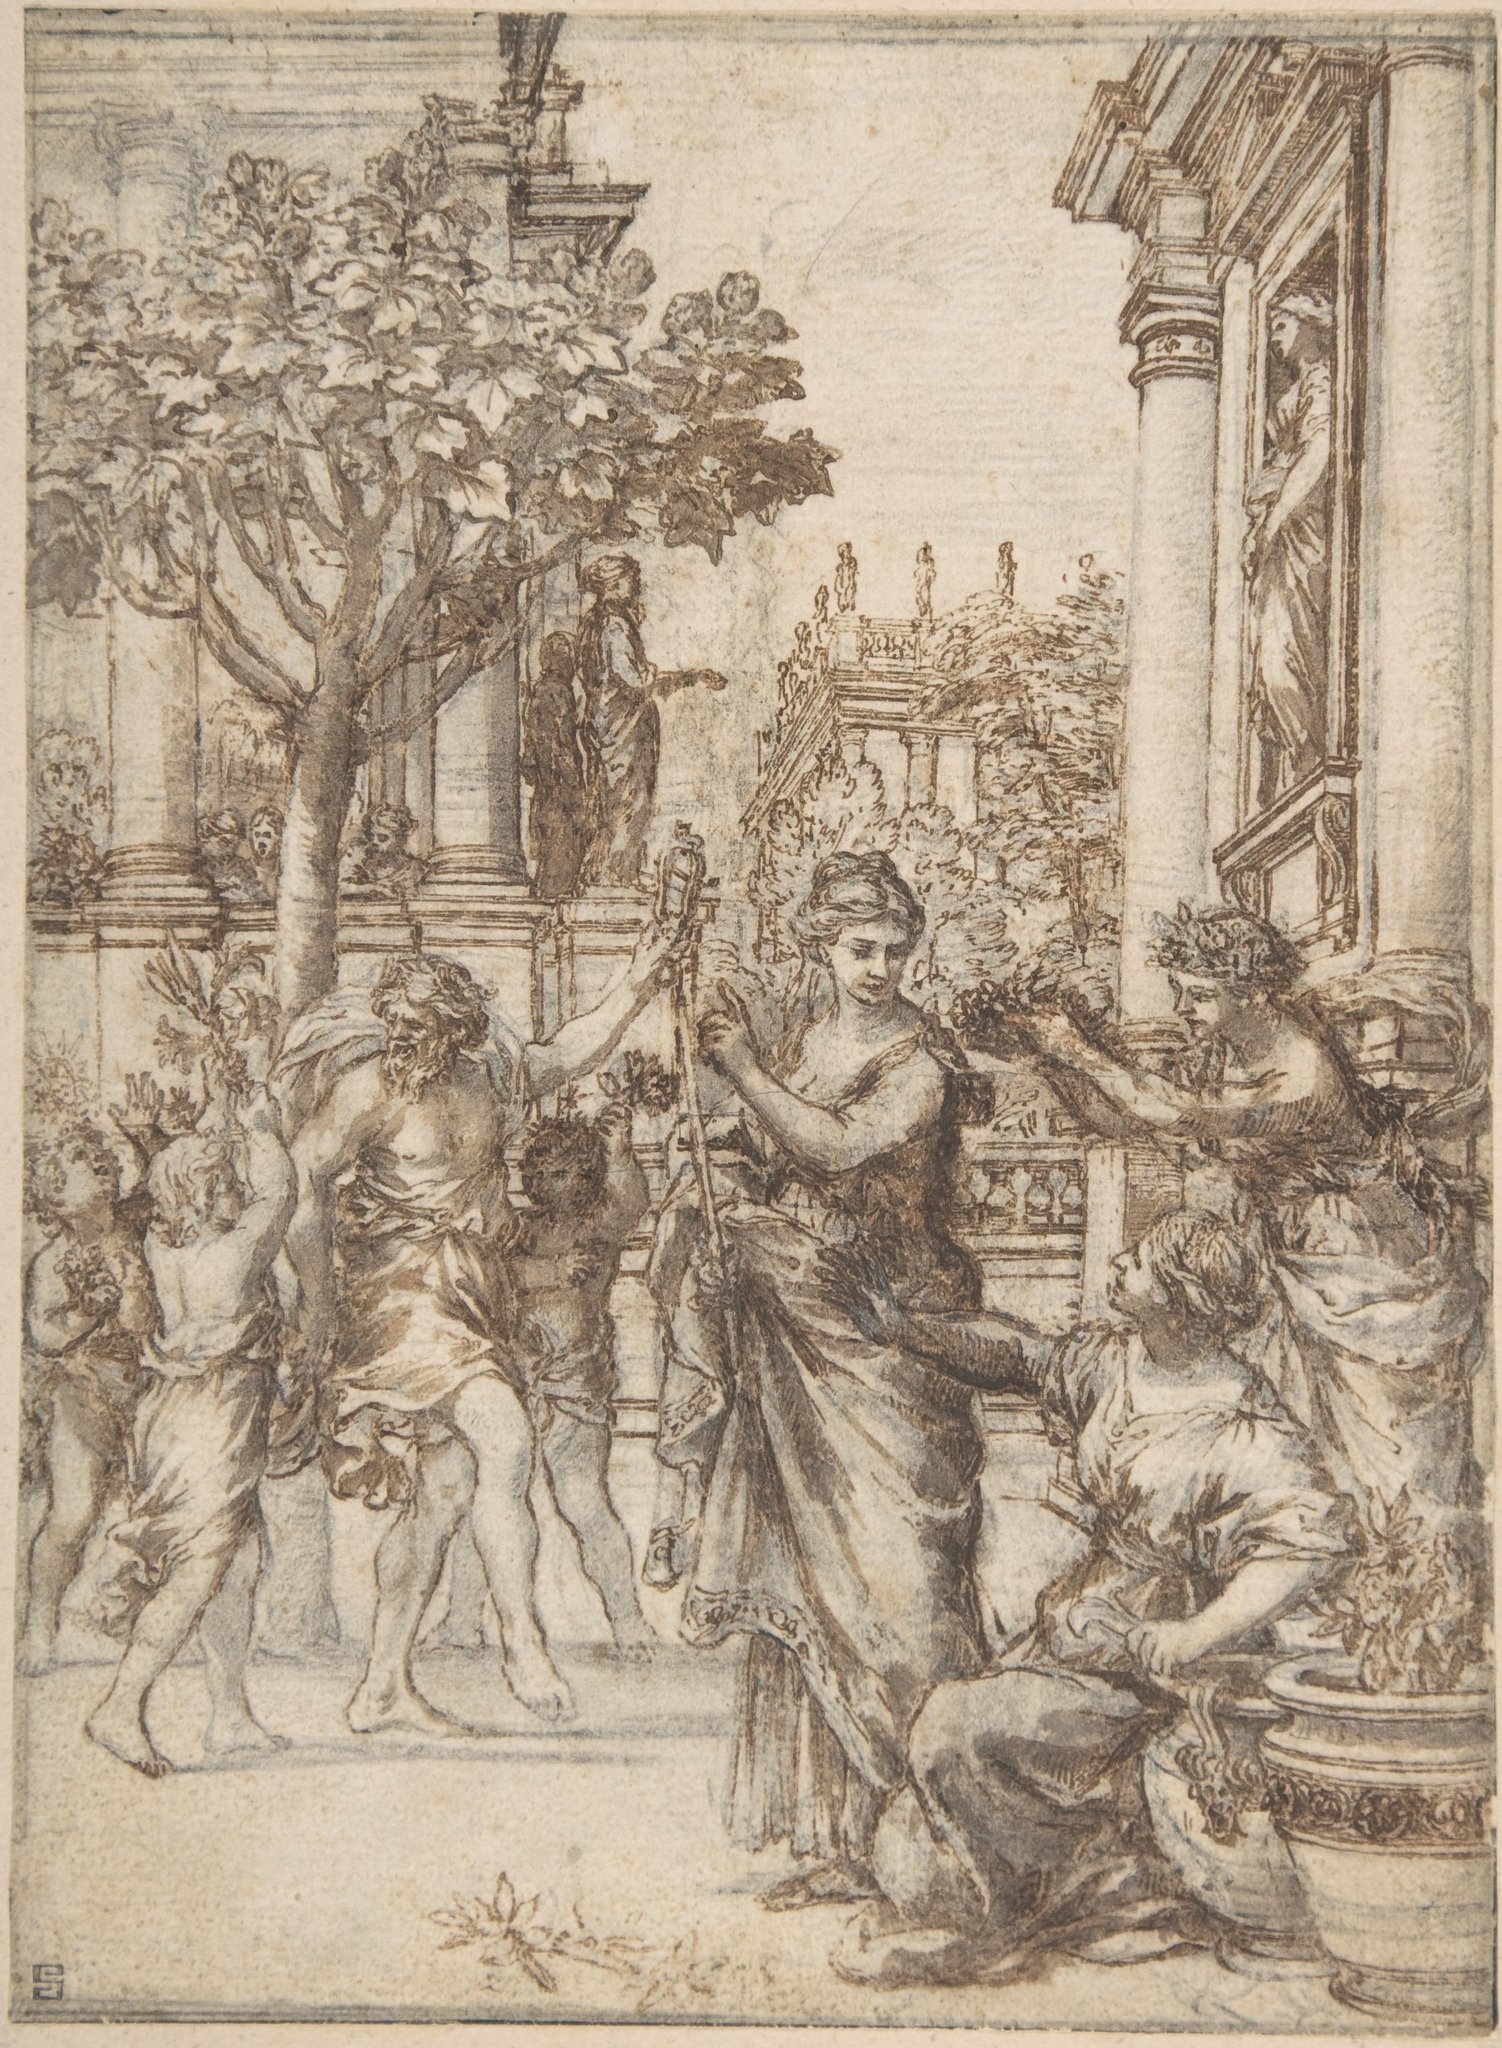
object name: drawing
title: The Triumph of Nature Over Art (design for an engraving of 'De Florum Cultura')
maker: pietro da cortona (pietro berrettini)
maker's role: artist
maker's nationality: italian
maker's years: 1596-1669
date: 1633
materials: chalk, ink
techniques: brush, pen, wash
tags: children,men,women,trees,allegory